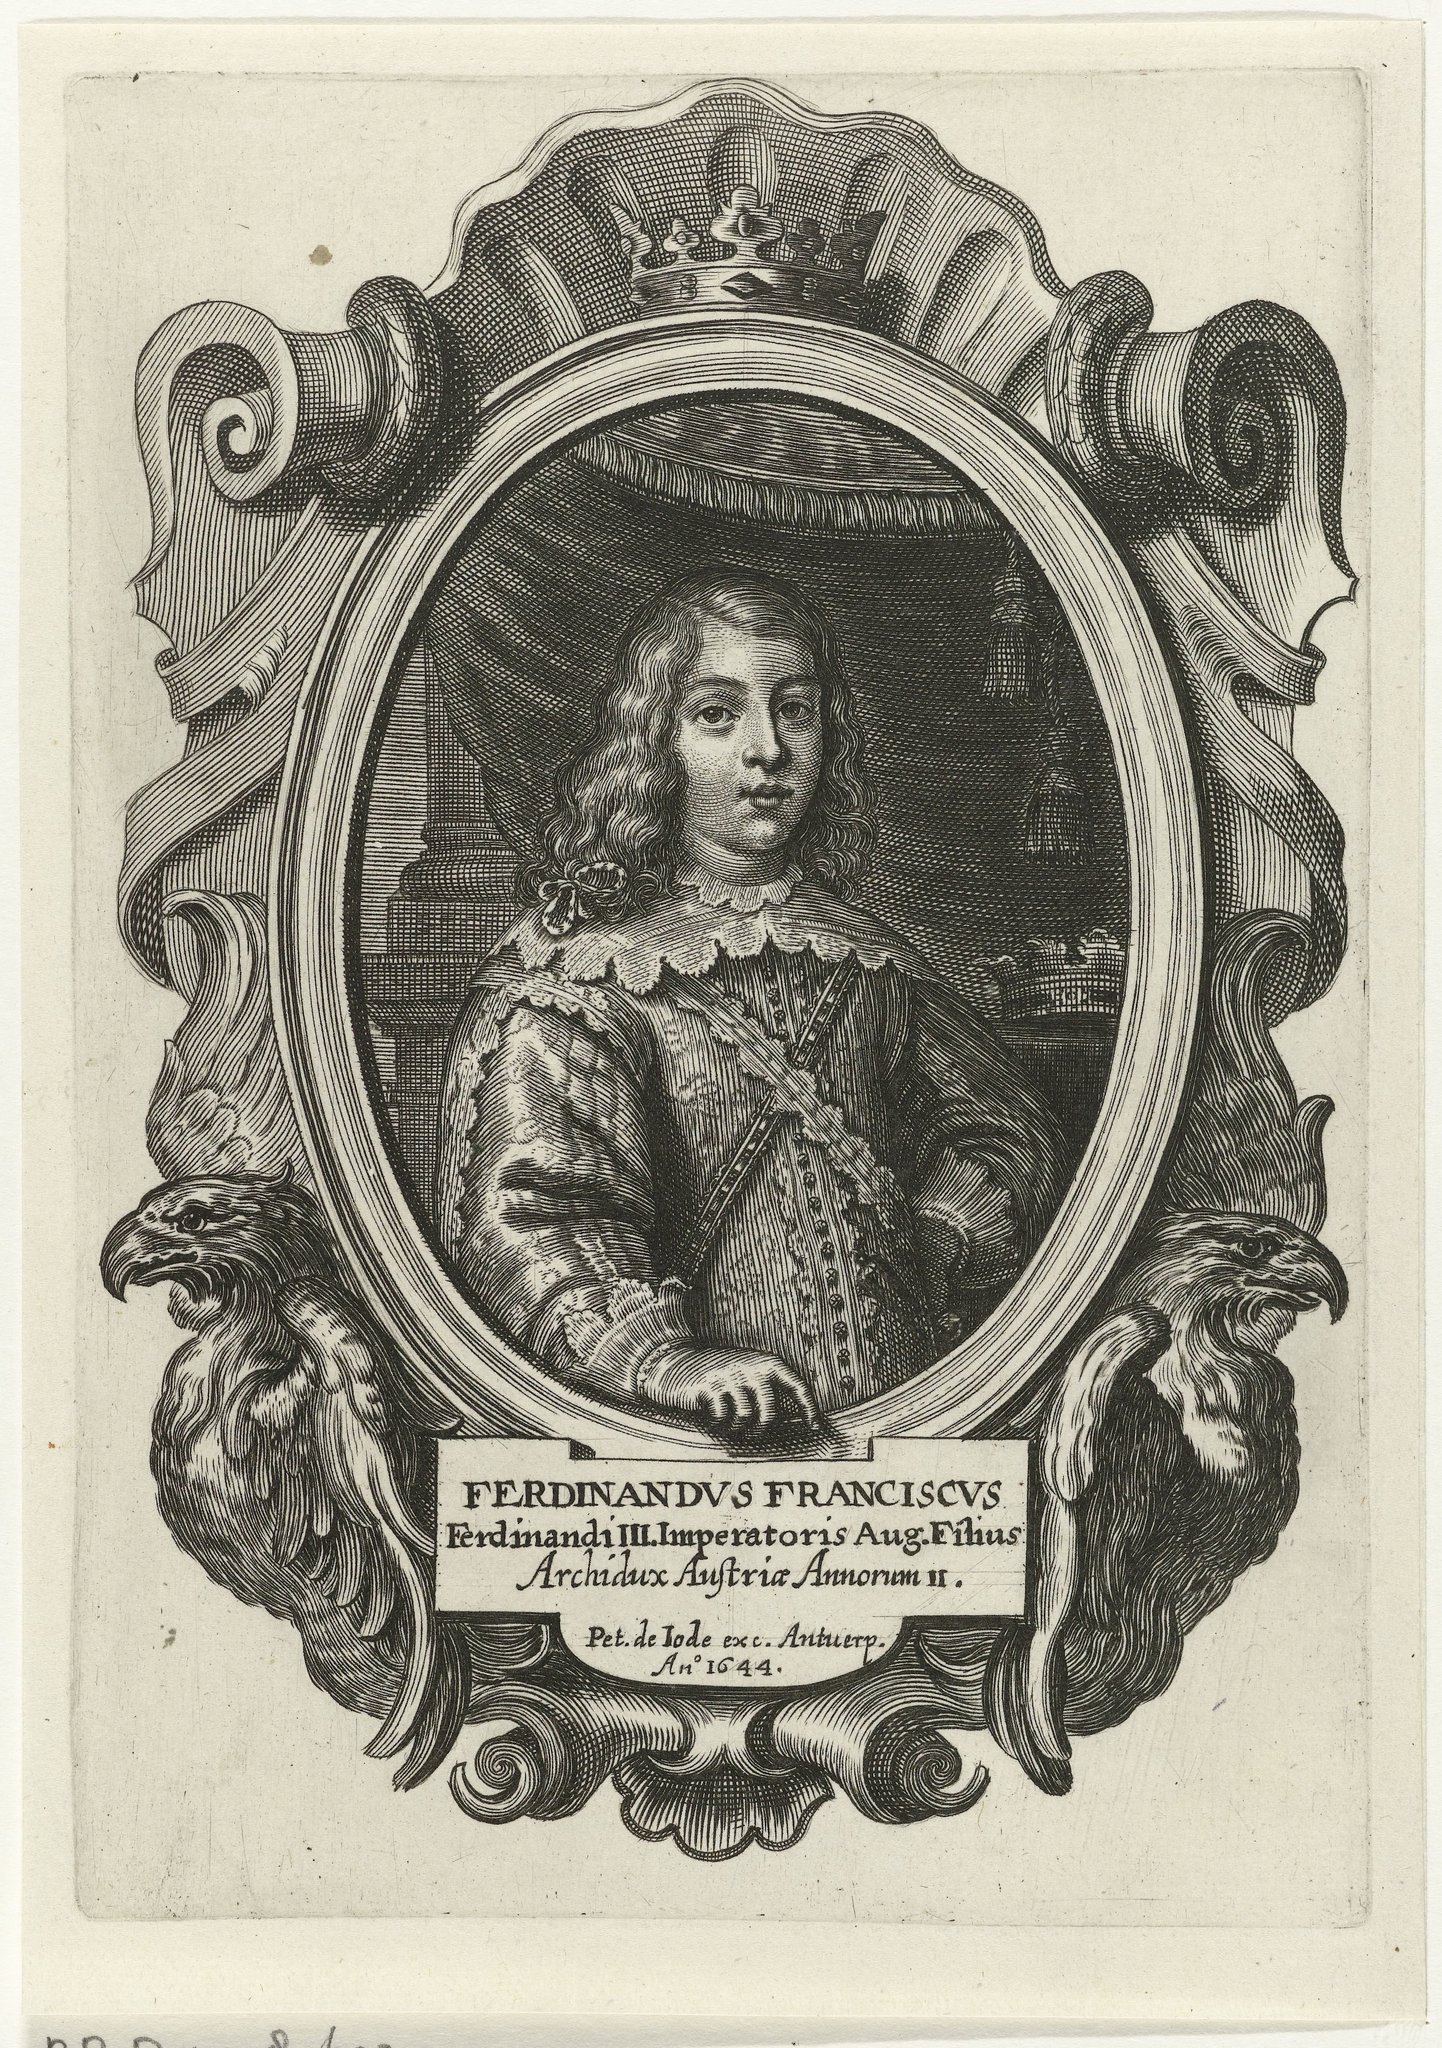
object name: print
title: Theater van bisschoppen, keizers, koningen, hertogen, prinsen, enz.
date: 1644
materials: paper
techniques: engraving, etching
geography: antwerp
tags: vienna, crown (symbol of sovereignty), ornament ~ cartouche (+ ornament enlivened by animal forms)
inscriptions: collector's mark: Lugt 2228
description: Portret van Ferdinand Franciscus (Ferdinand IV, koning van Hongarije, Bohemen en het Heilige Roomse Rijk), oudtste zoon van keizer Ferdinand III. Hij houdt zijn linkerhand in zijn zij en met zijn rechterhand wijst hij naar het kader onder de omlijsting. Op de achtergrond een kroon. Het portret is gevat in een ovale omlijsting in een cartouche met adelaars en een kroon. In het kader een drieregelig onderschrift in het Latijn.